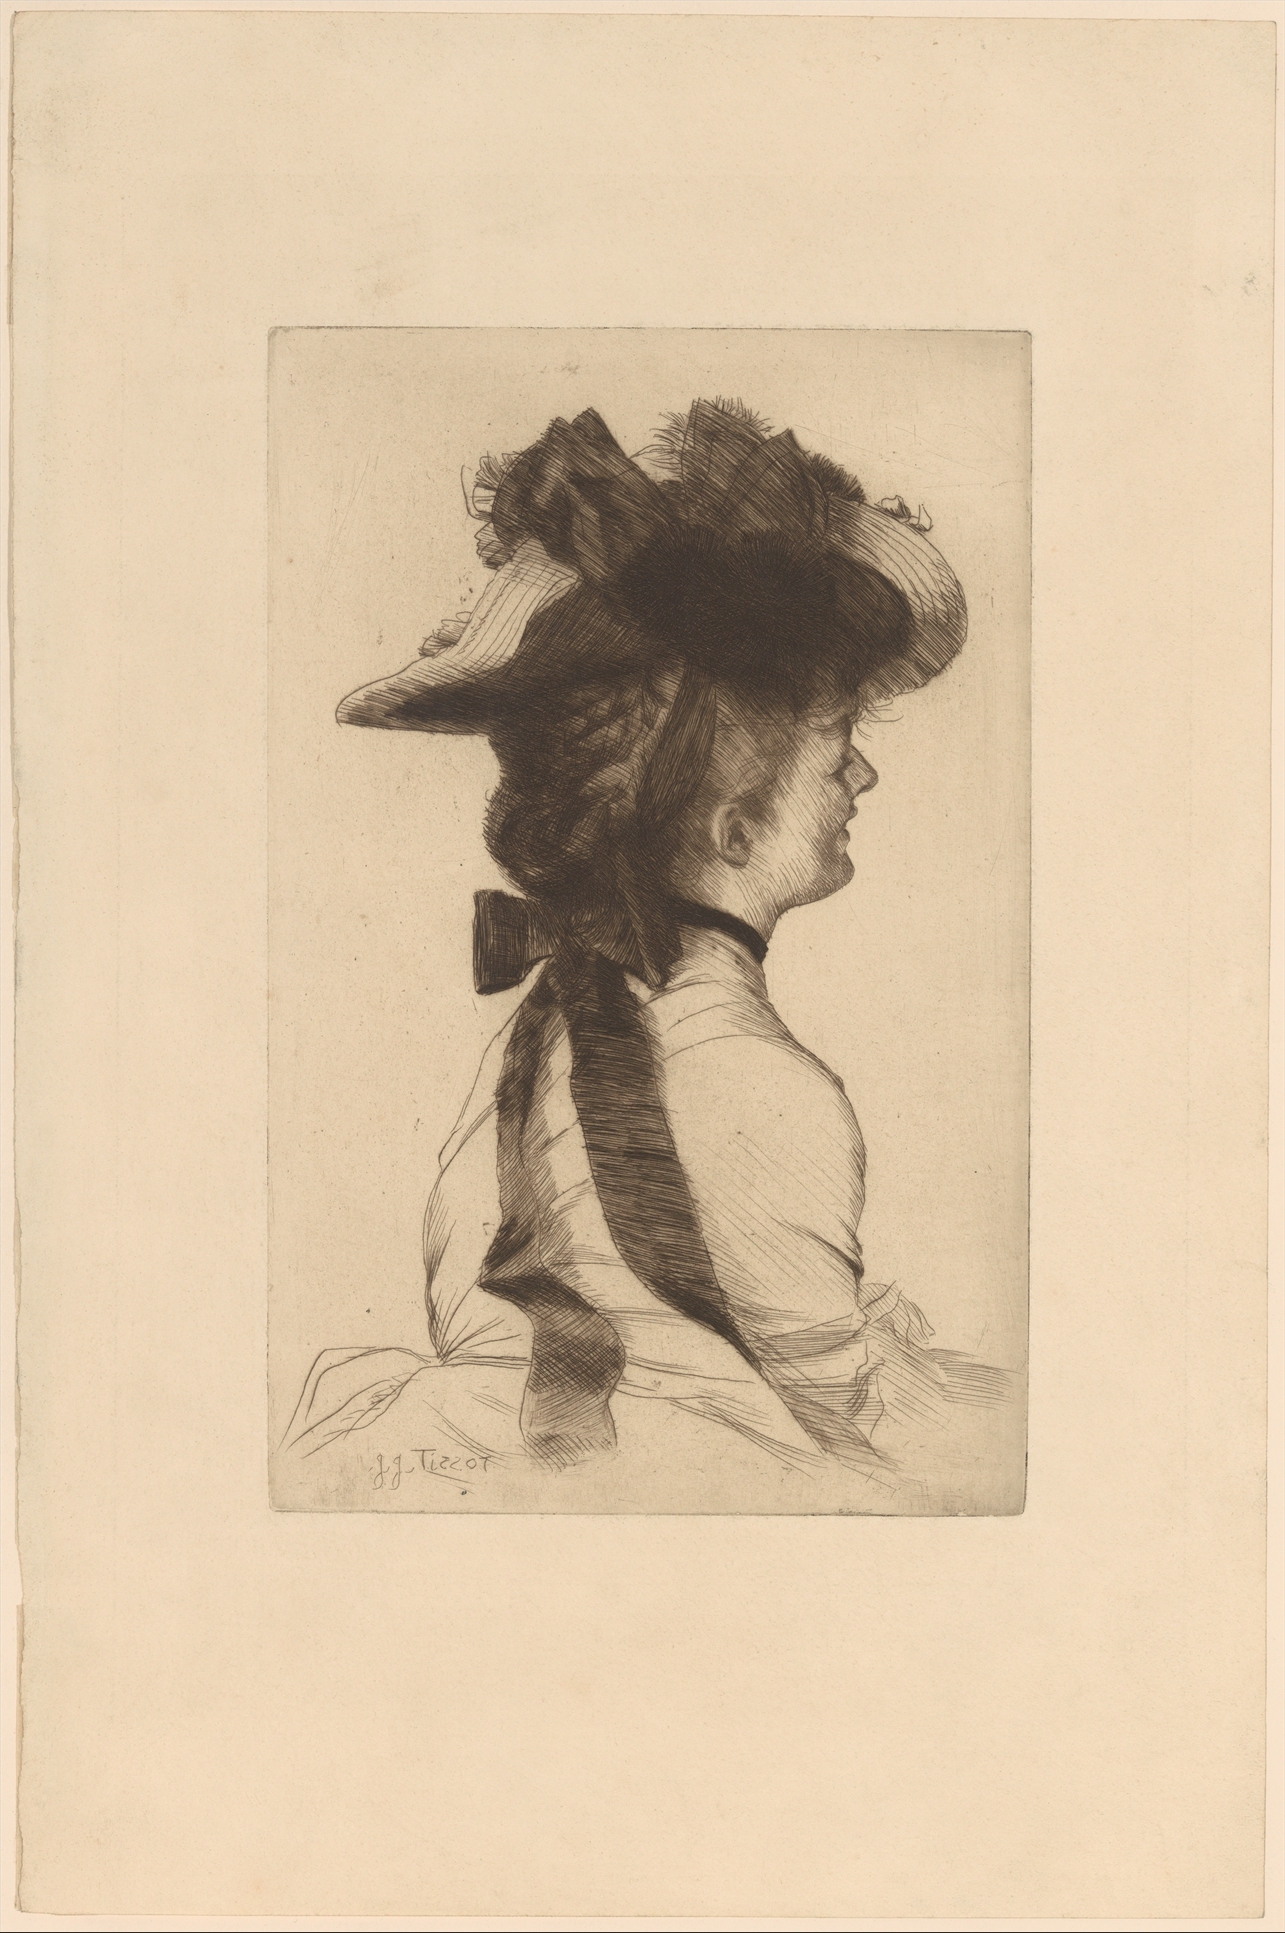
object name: print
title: The Rubens Hat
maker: james tissot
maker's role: artist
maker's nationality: french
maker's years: 1836-1902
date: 1875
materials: ink, paper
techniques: etching, printing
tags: hats,women